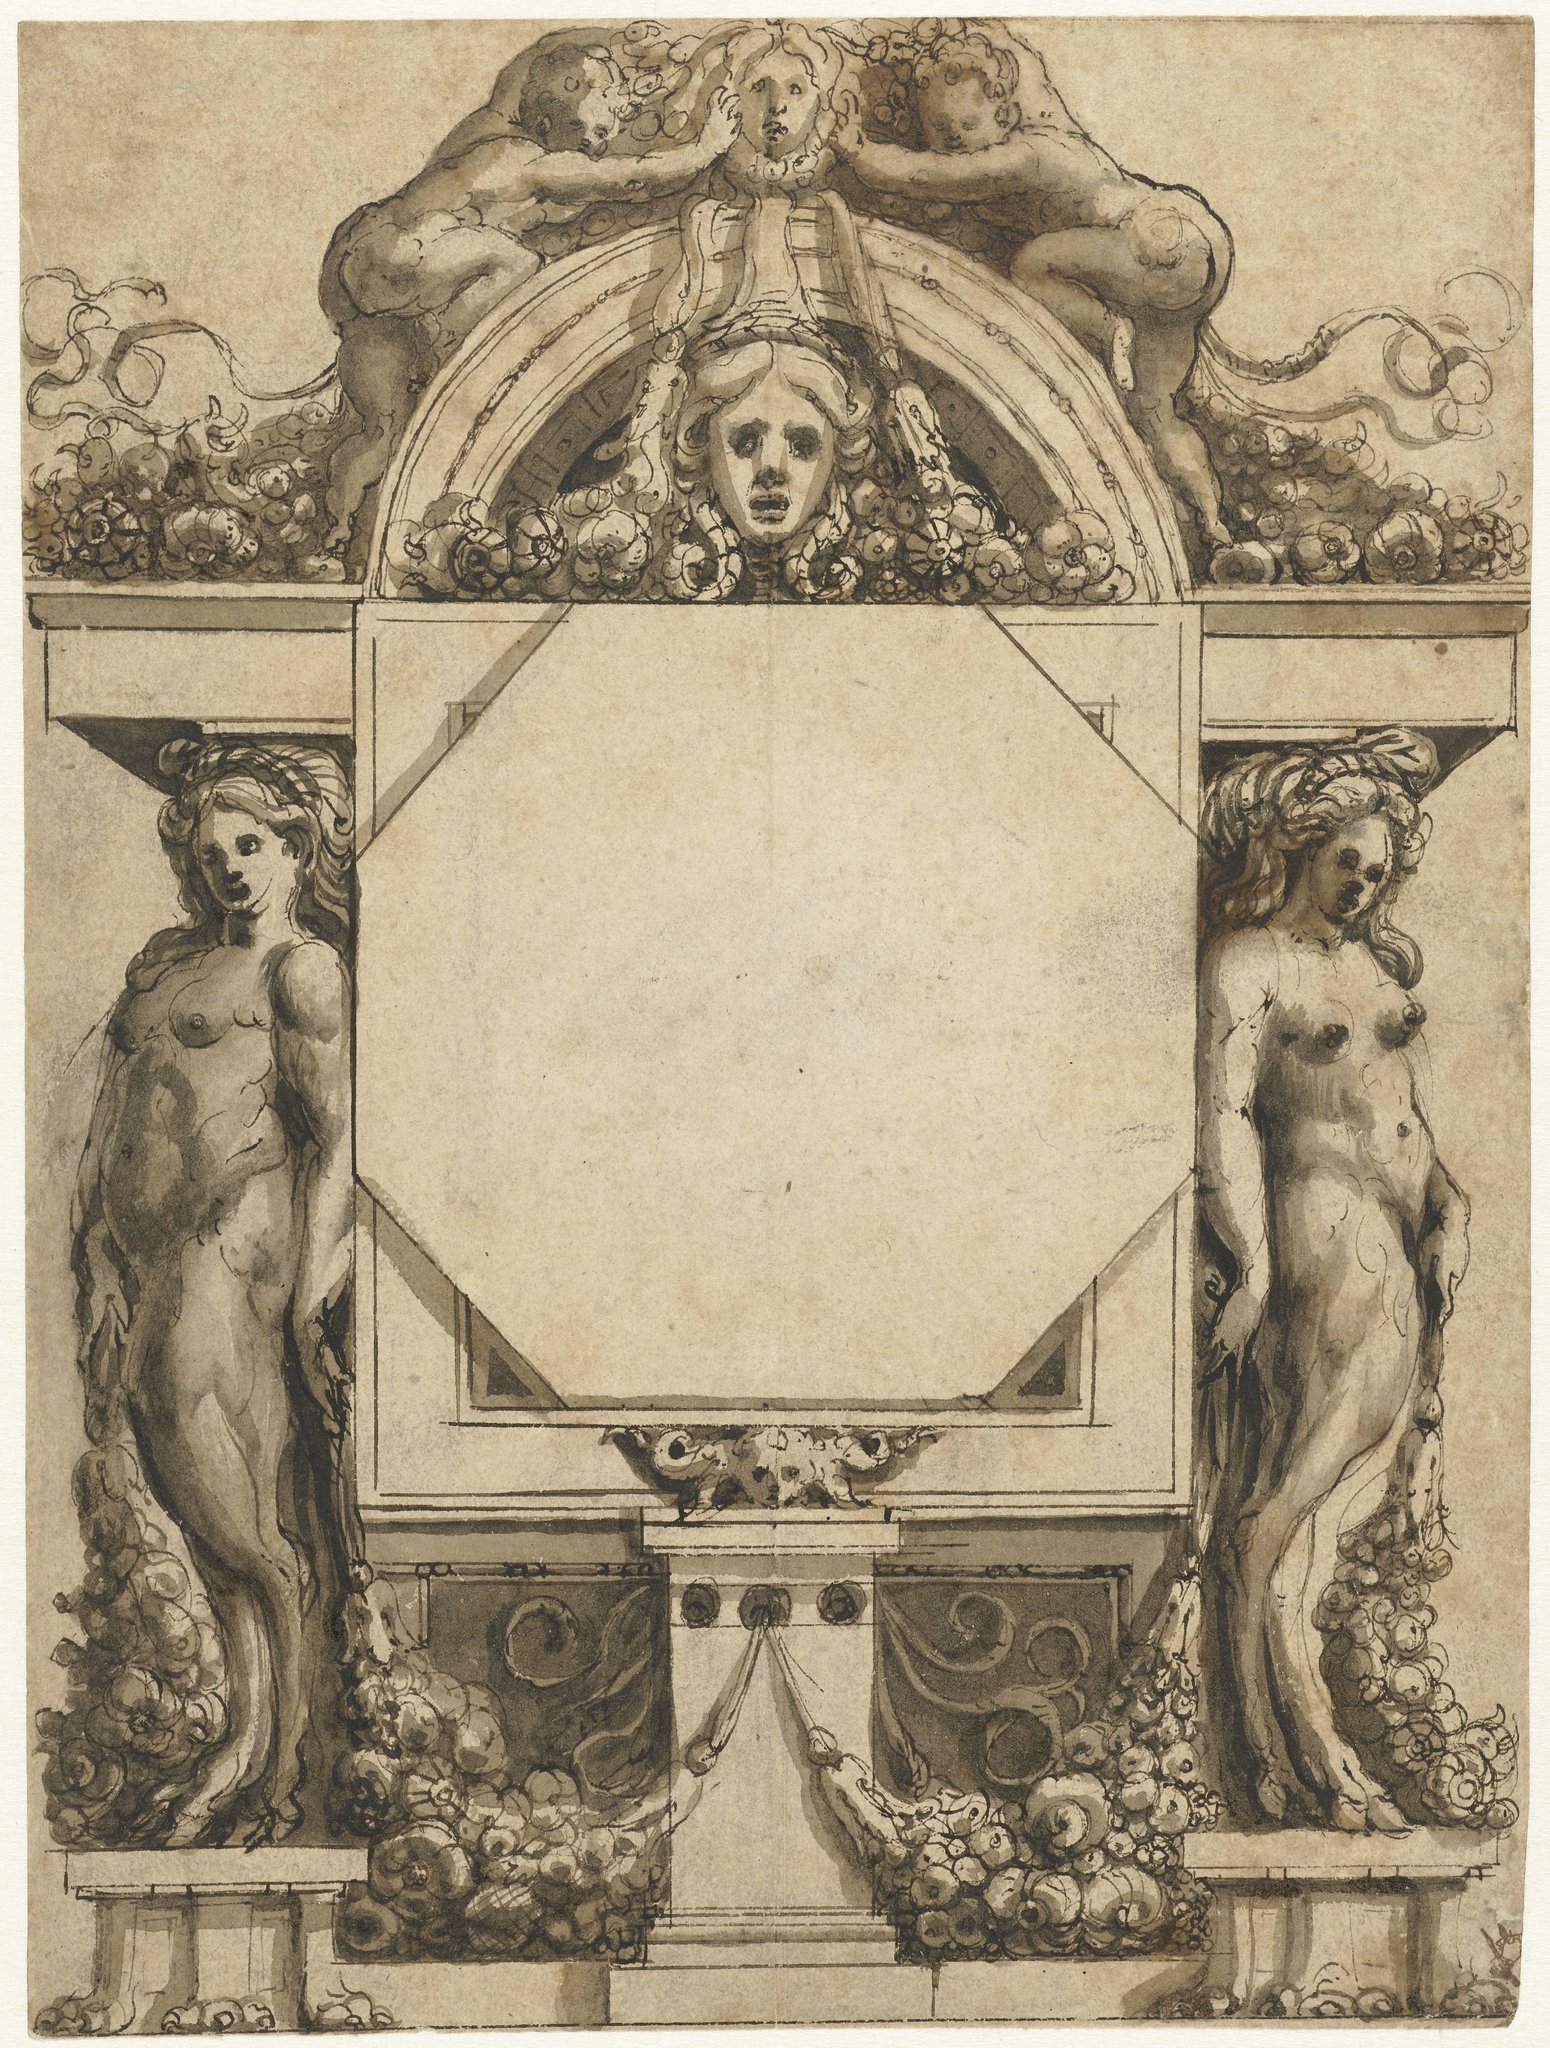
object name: drawing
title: Ontwerp voor een wanddecoratie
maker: cigoli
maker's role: draughtsman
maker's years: 1559-1613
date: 1569-1610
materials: ink, paper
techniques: brush, pen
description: Deel van een trompe l'oeil versiering van een gevel, met twee vrouwenfiguren links en rechts van een middenstuk waarop een boogvormige constructie met daarin een kop en daarboven twee putti die een kop in een krans vasthouden. Het geheel steunt op zuiltjes met ornamentdecoratie.